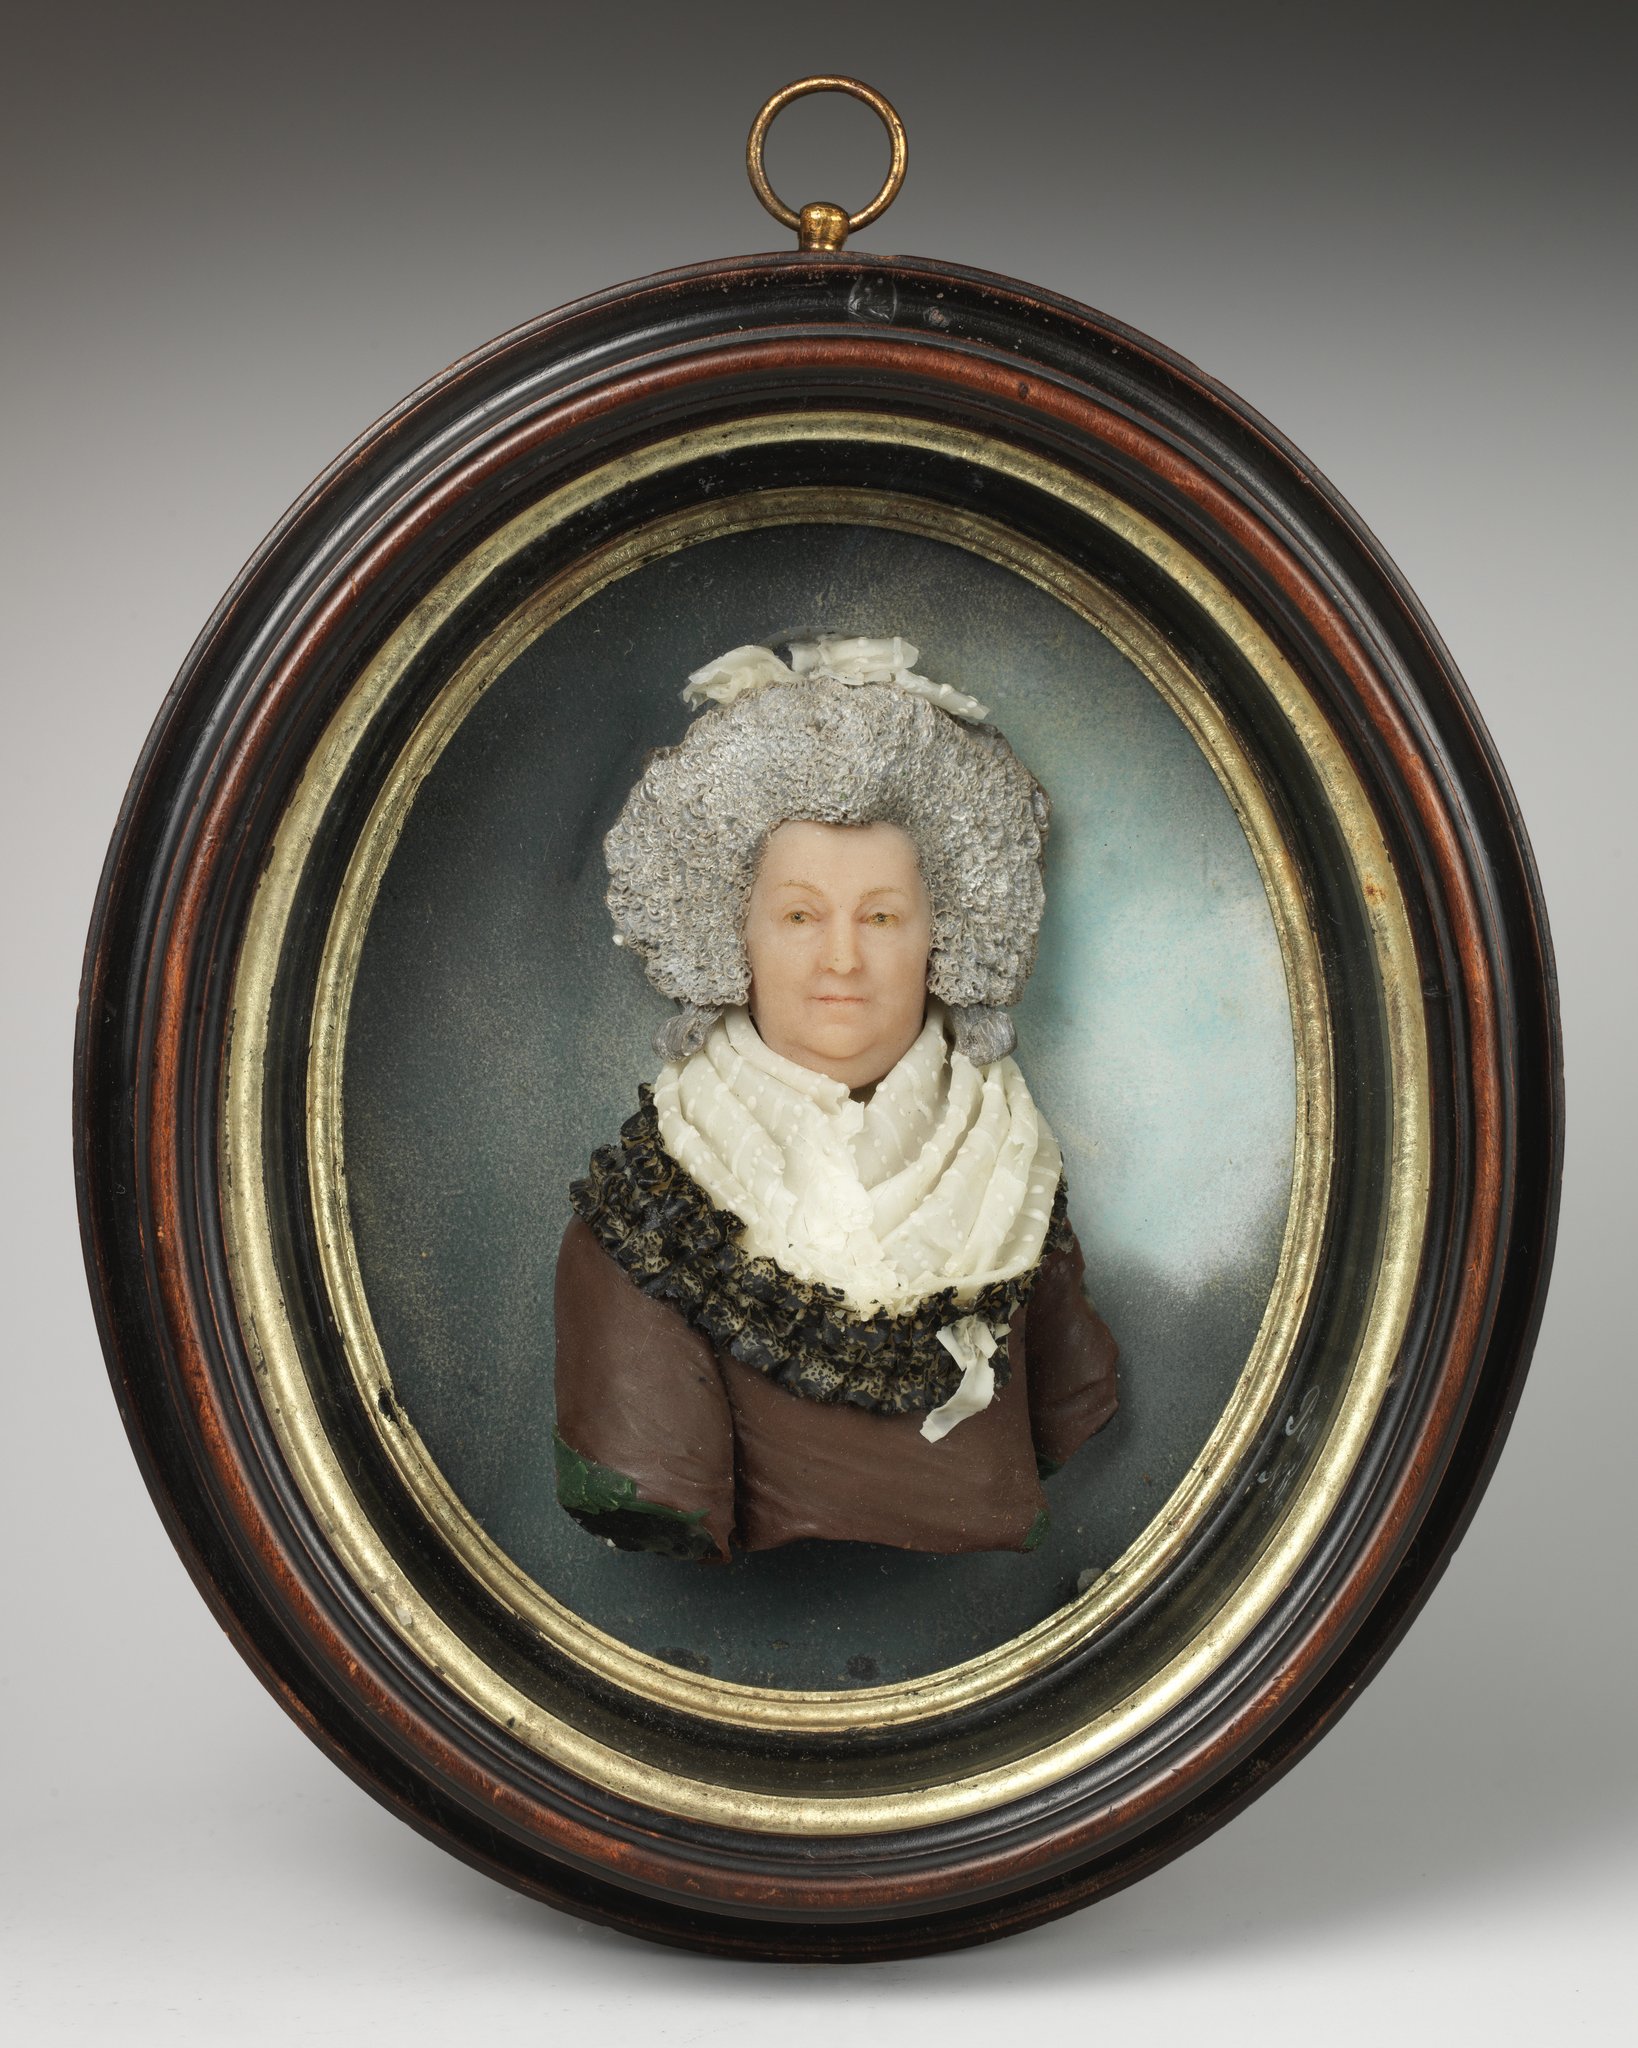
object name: sculpture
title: Portrait of a Lady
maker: samuel percy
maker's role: artist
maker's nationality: irish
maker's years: 1750-1820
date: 1767-1800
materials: glass, paper, wax, wood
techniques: gilding, tinting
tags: portraits,women